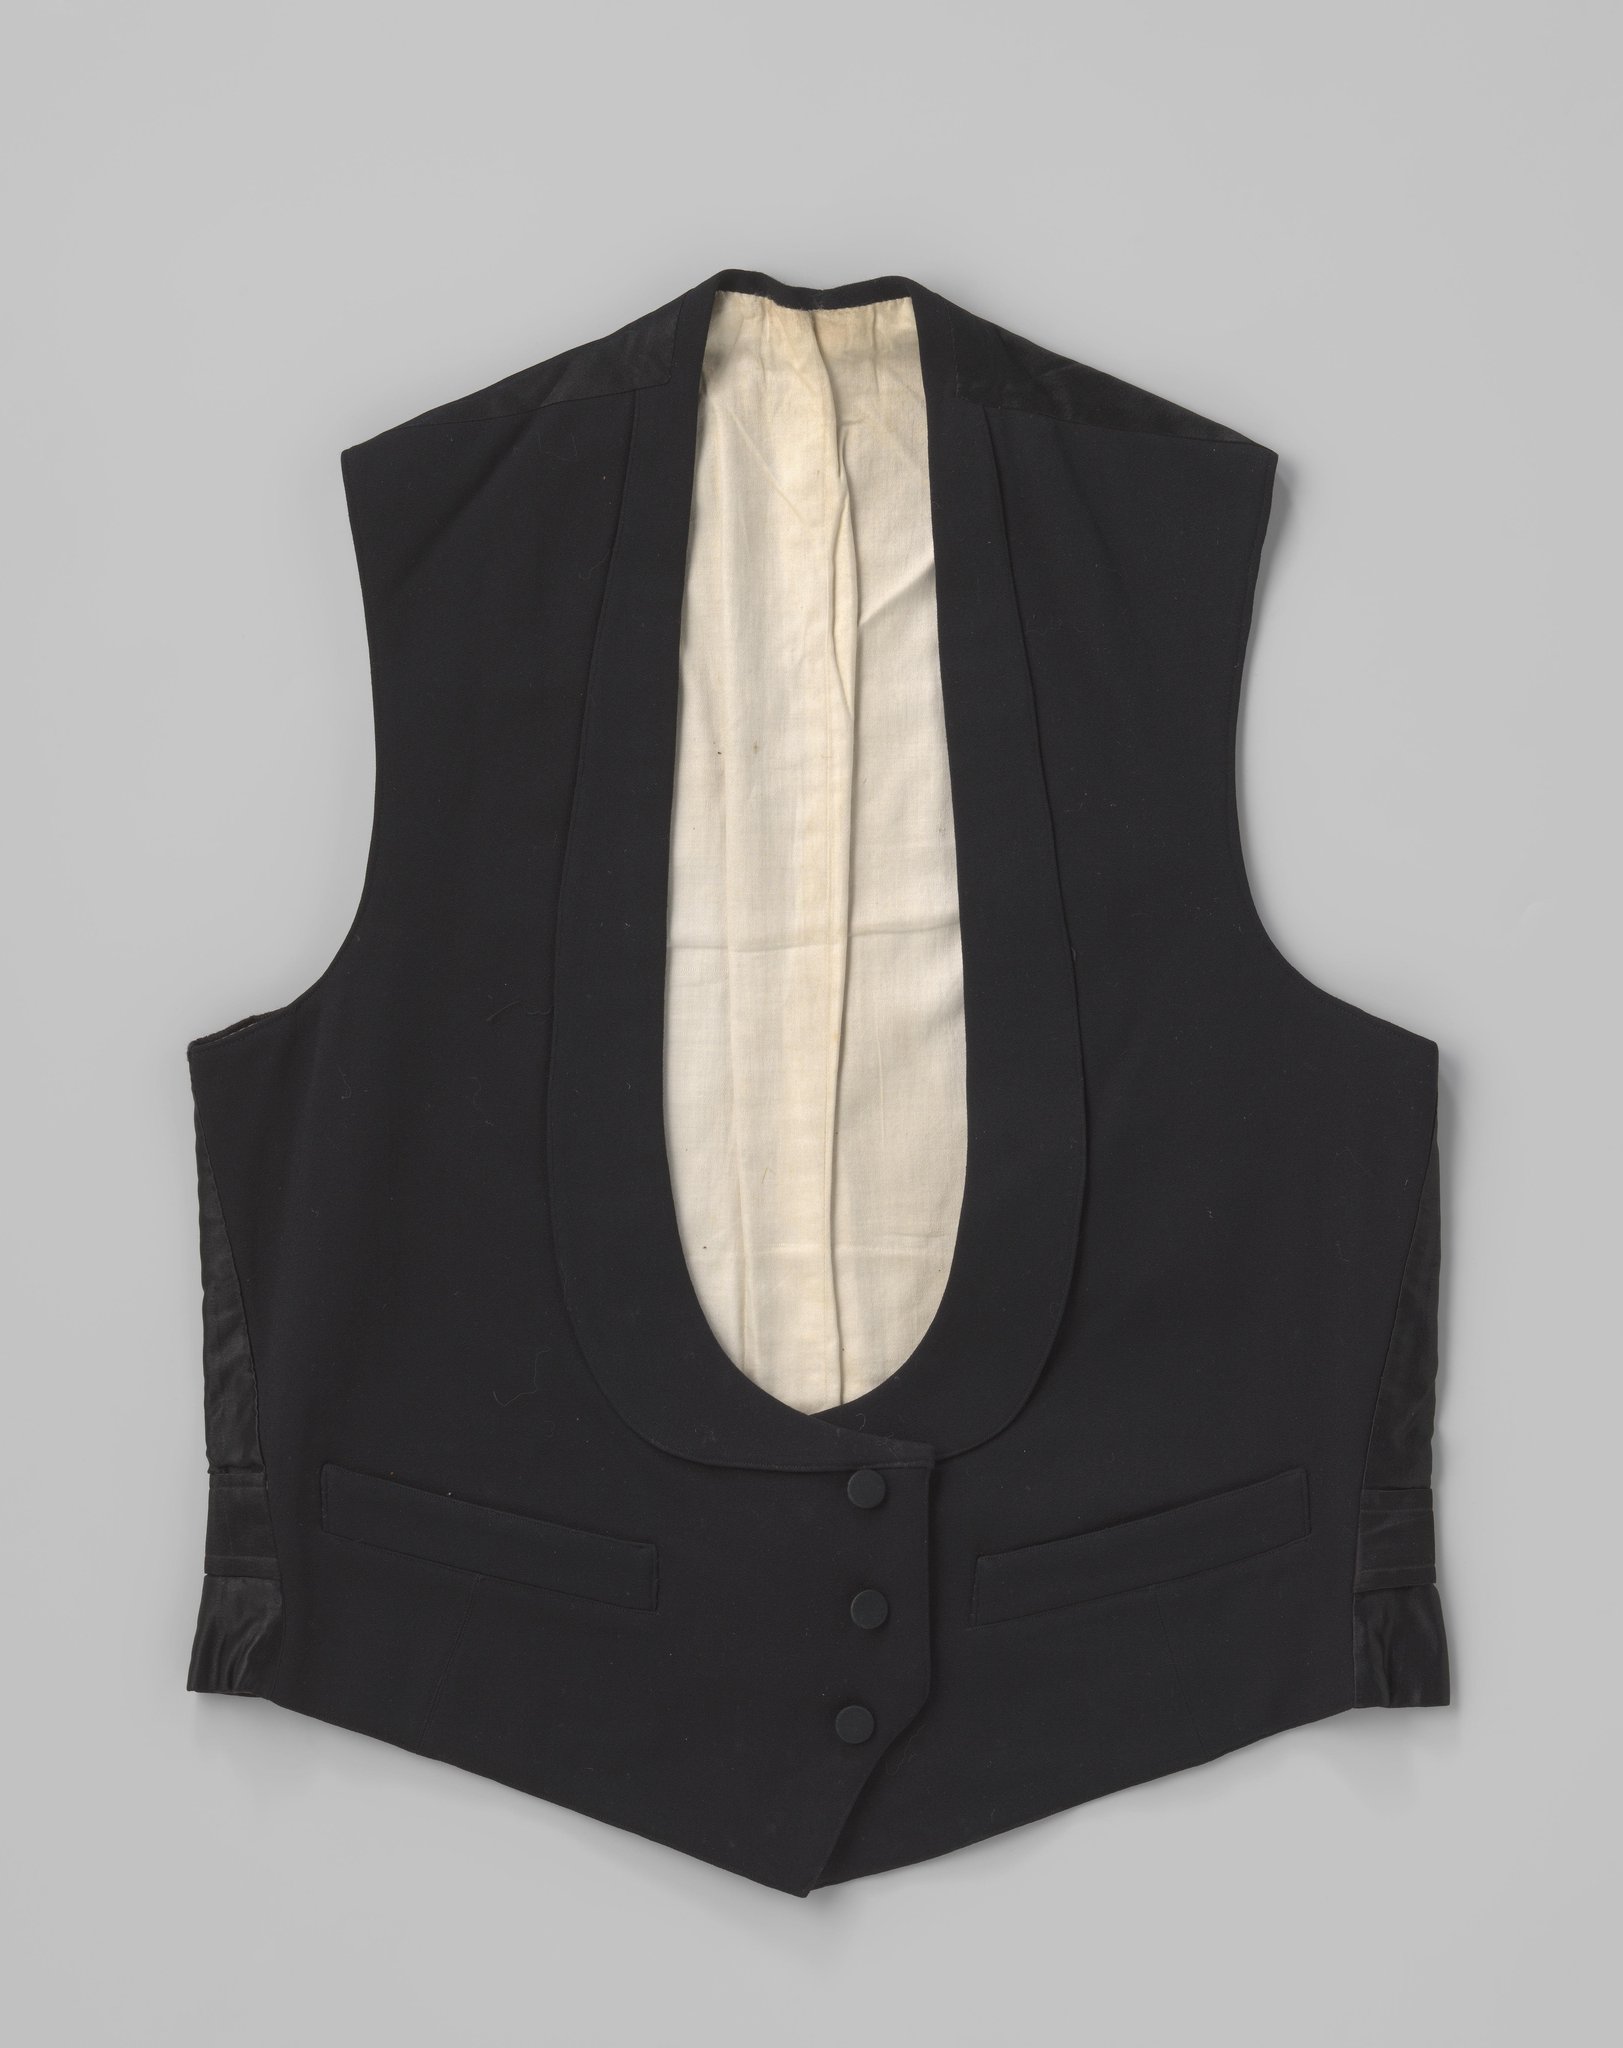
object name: rokvest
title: Vest van zwarte wol met zeer diepe afgeronde halslijn met ronde kraag, schuin weggesneden voorpanden, drie zijden stofknopen en twee insteekzakken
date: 1910-1915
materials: textile, silk, wool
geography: brussels